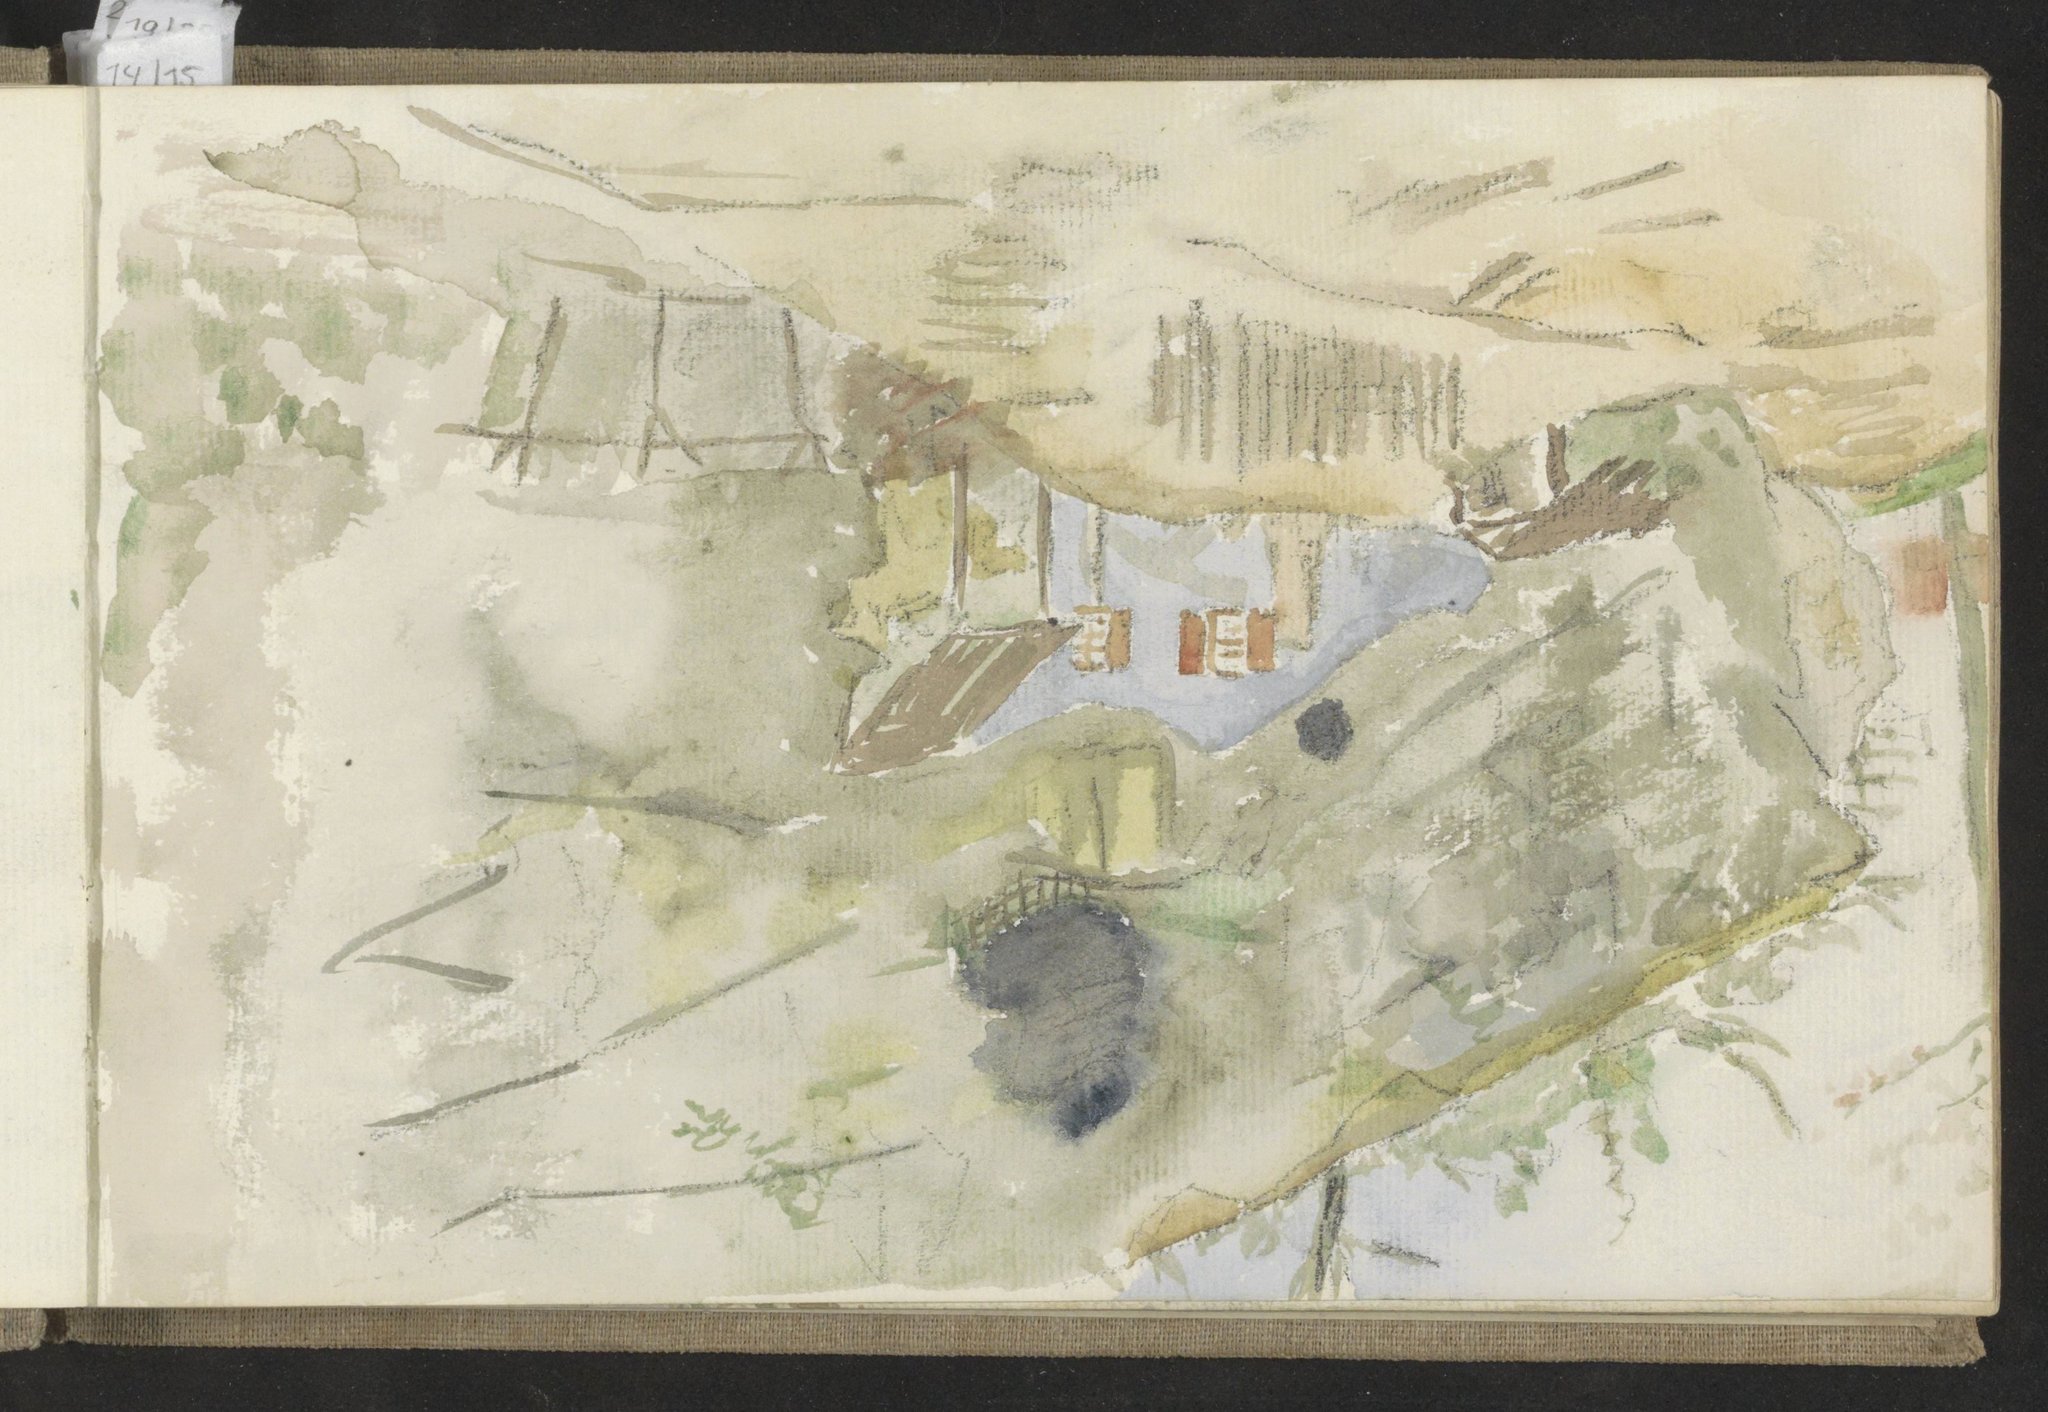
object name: sketchbook leaf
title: Huis en schuur aan de voet van een heuvel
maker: jonkheer johannes ludovicus paulus bosch van drakestein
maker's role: draughtsman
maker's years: 1865-1929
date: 1896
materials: paper, pencil, watercolor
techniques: brush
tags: low hill country, shed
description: Blad 10 recto uit een schetsboek met 58 bladen.